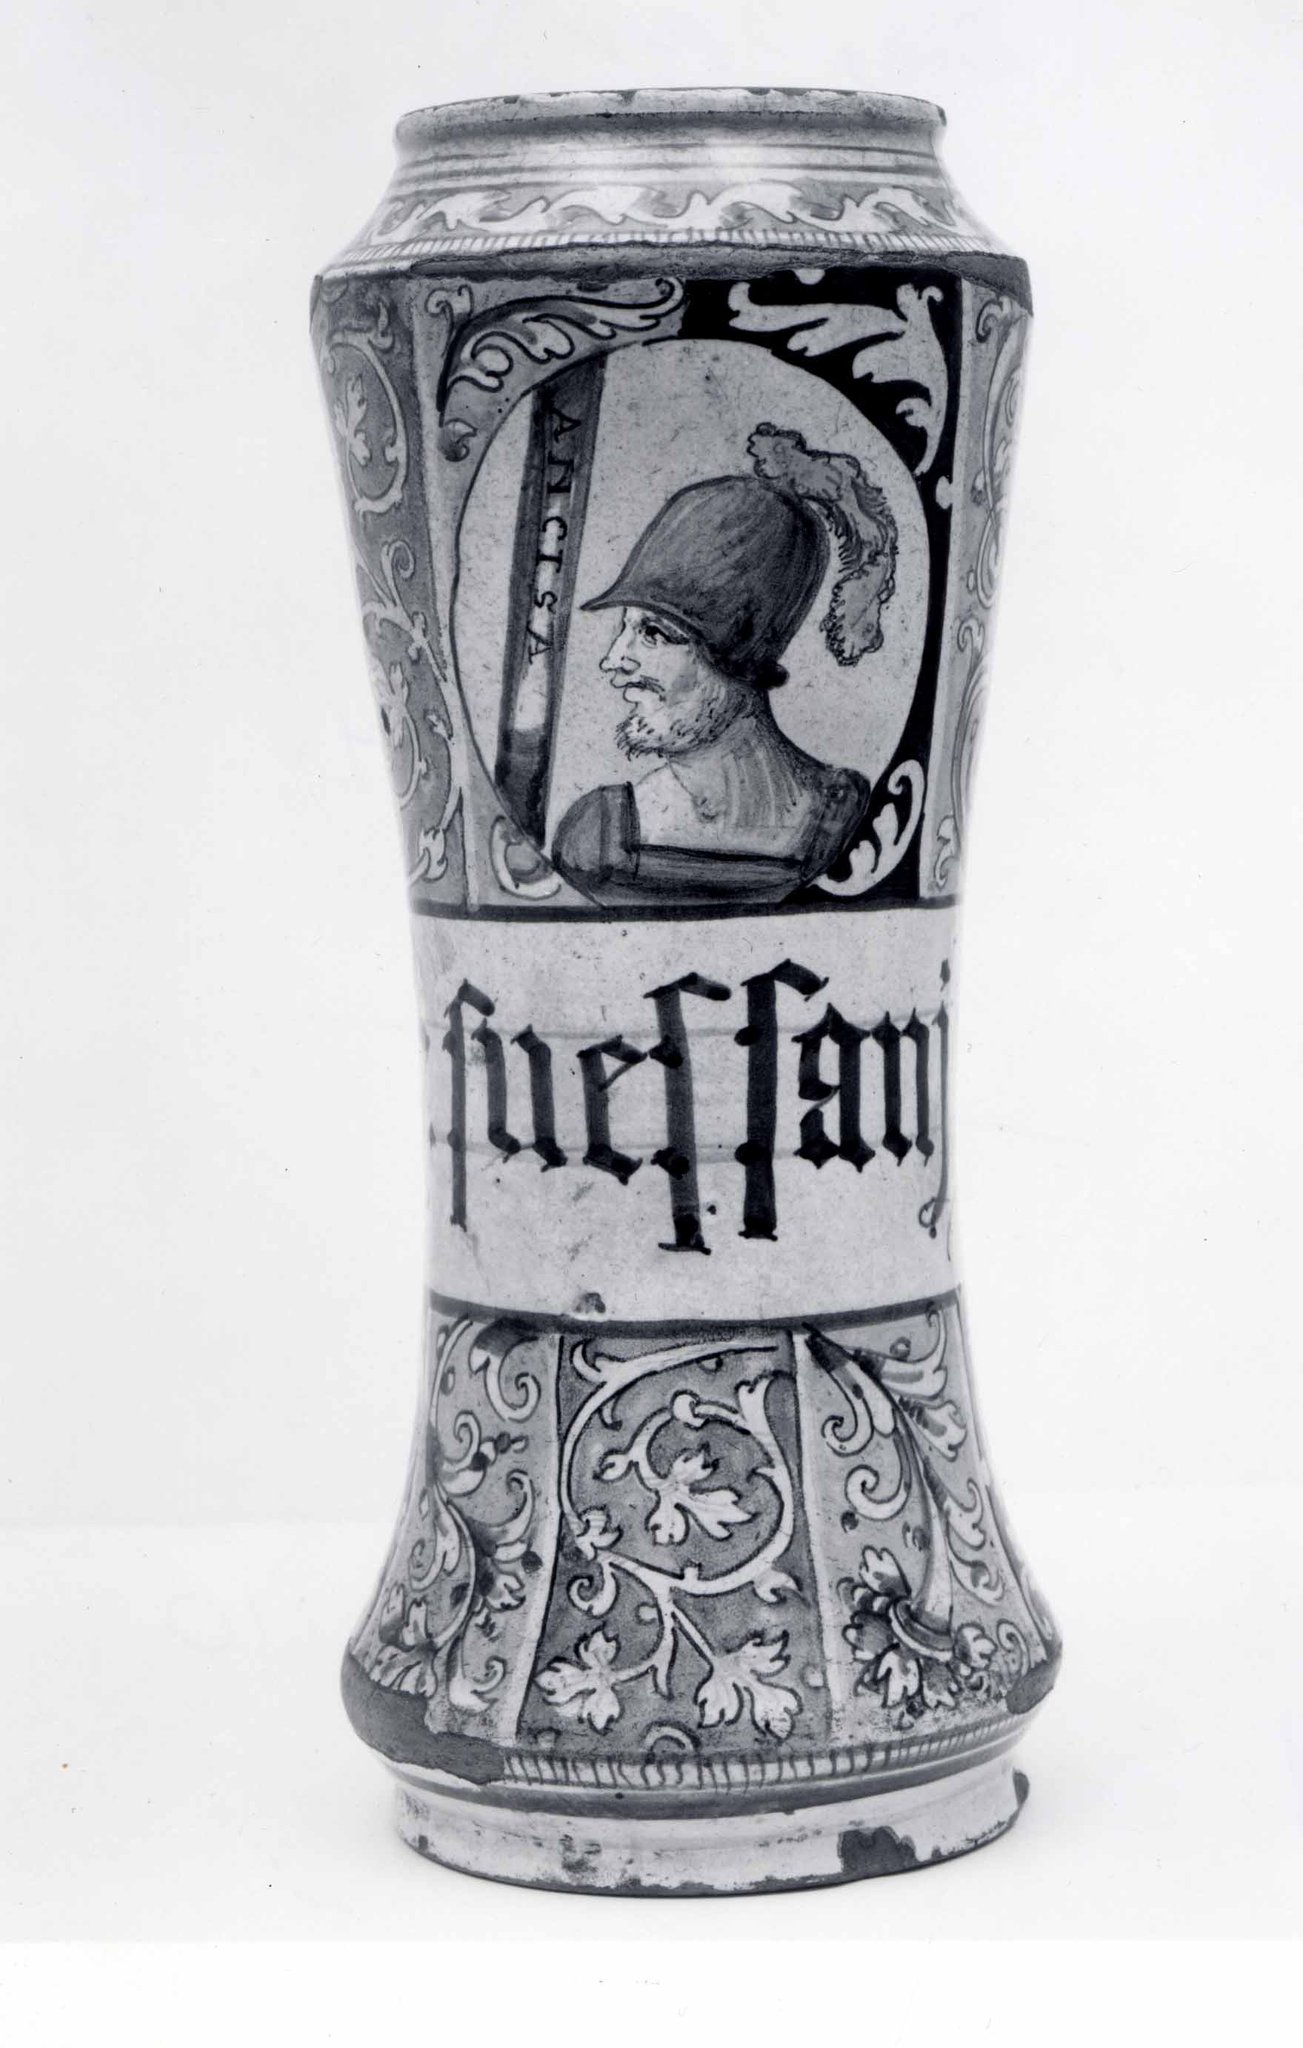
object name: albarello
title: Apothecary jar (albarello)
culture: italian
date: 1550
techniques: maiolica, glazing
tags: men